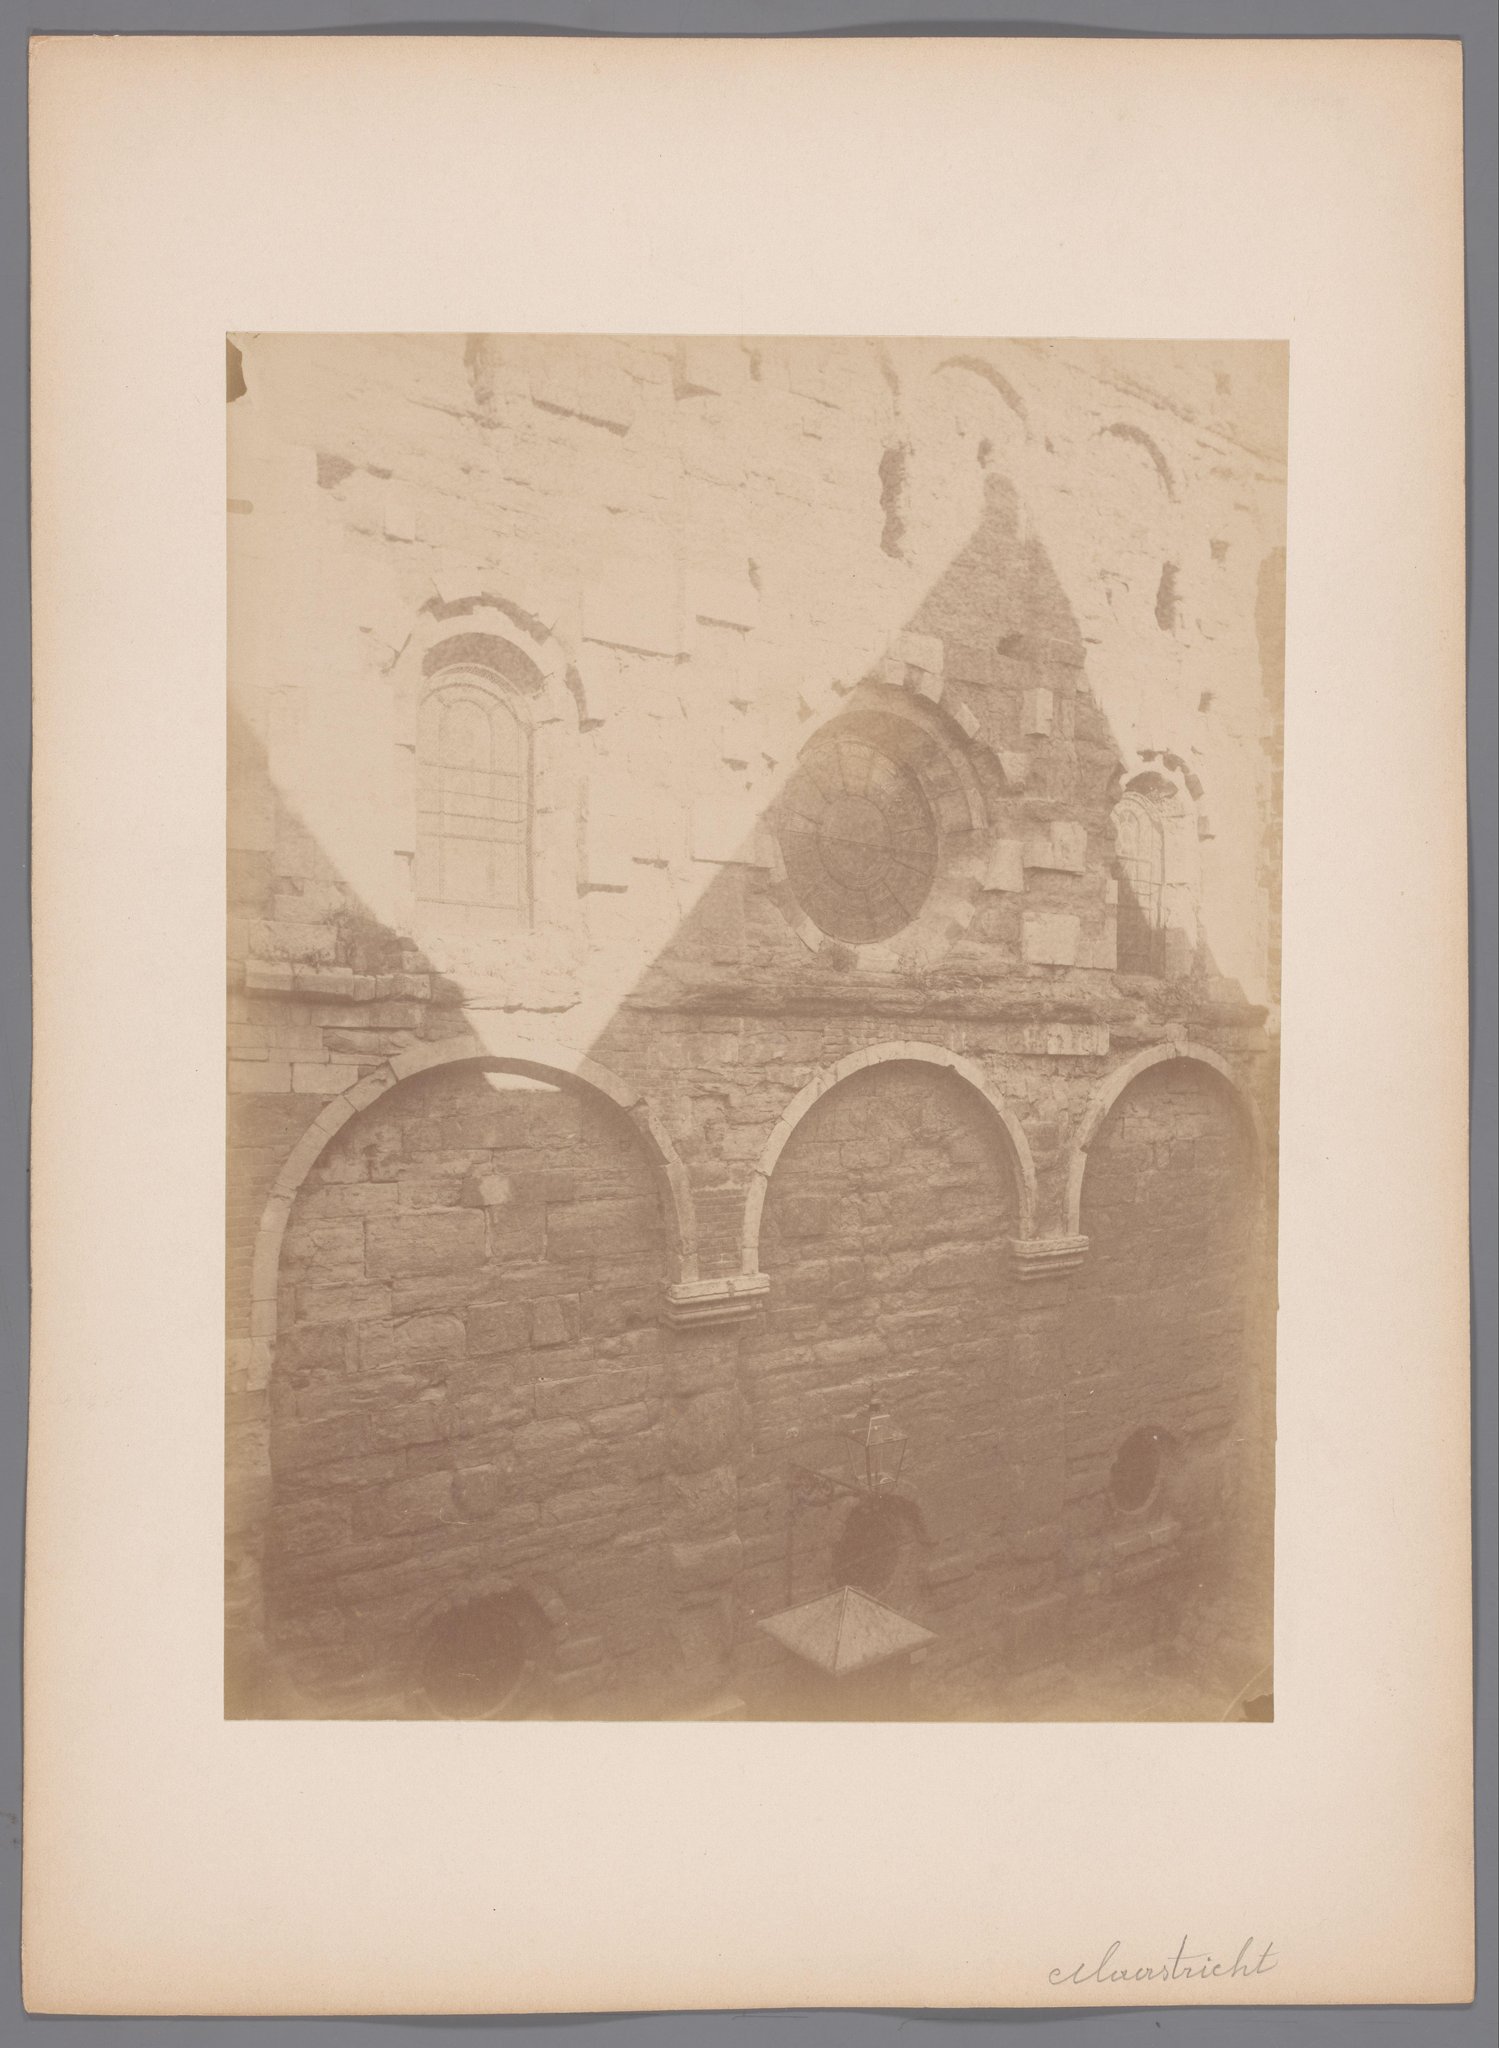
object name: photograph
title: Detail van de torens van de Sint-Servaasbasiliek te Maastricht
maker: anoniem (monumentenzorg)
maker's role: fotograaf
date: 1893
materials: cardboard, photographic support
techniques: albumen print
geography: maastricht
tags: parts of church exterior and annexes: tower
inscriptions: annotation: ‘Maastricht St. Servaas/ Westzijde v/d torens (noord’, annotation: ‘Maastricht’